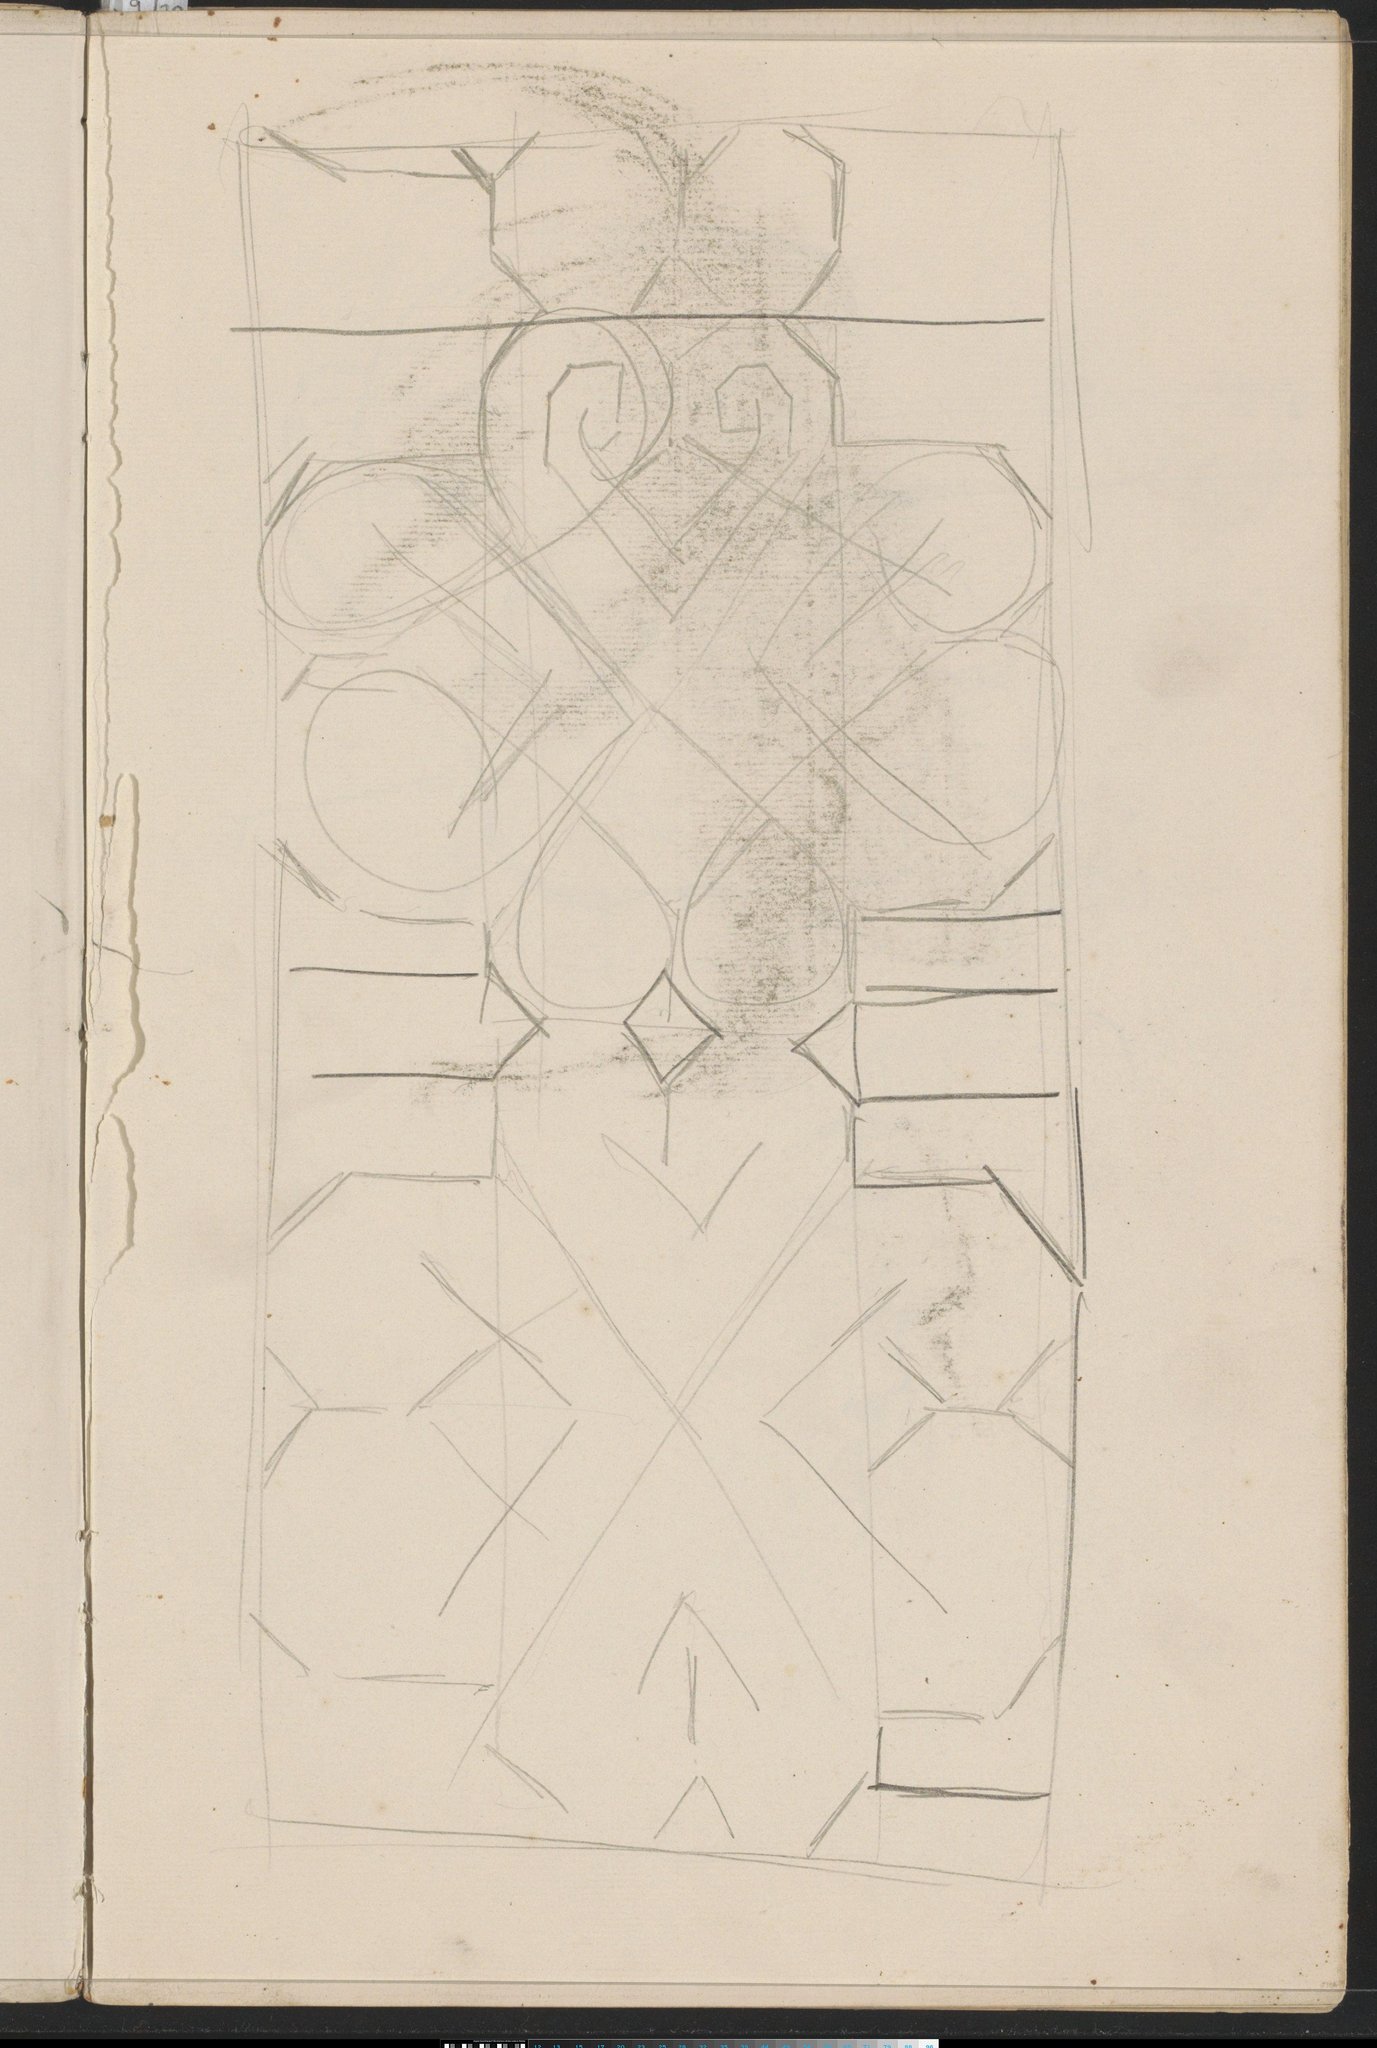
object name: sketchbook leaf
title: Ornament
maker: carel adolph lion cachet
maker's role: draughtsman, print maker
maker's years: 1864-1945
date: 1897-1898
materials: paper, pencil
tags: ornaments ~ art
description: Blad 9 recto uit een schetsboek met 29 bladen.